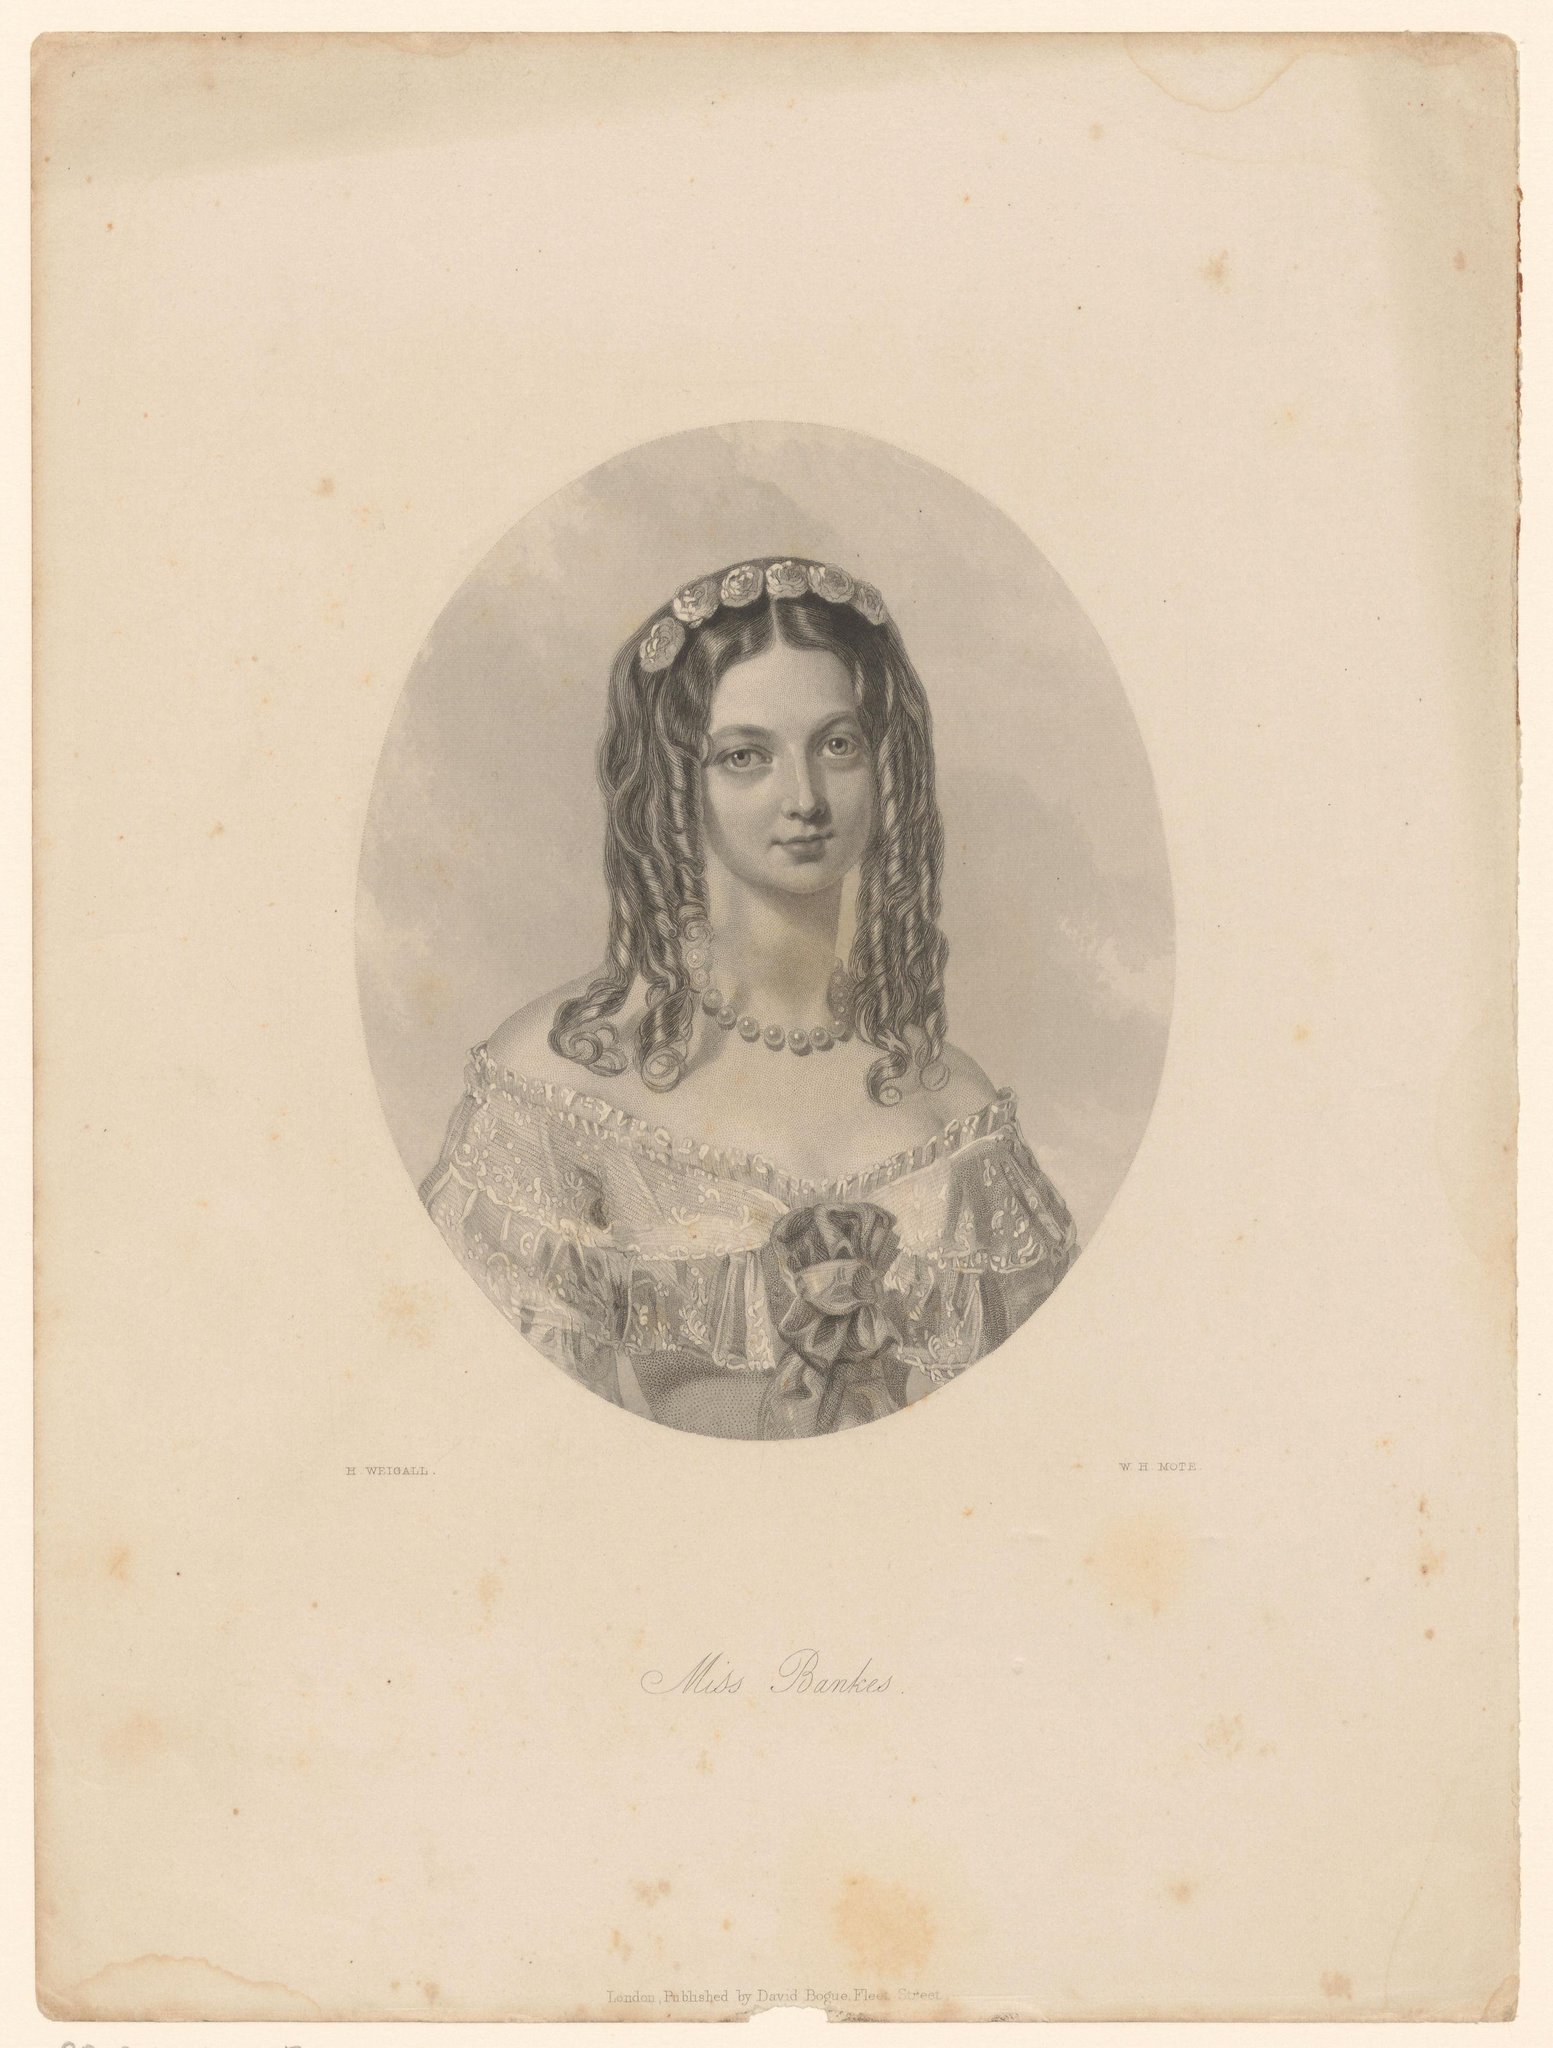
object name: book illustration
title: Miss Bankes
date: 1854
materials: paper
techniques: etching, engraving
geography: england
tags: historical persons - bb - woman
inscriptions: collector's mark: Lugt 2228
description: Prent uit: The Court Album: A Series of Portraits of the Female Aristocracy. Londen: David Bogue, 1854.